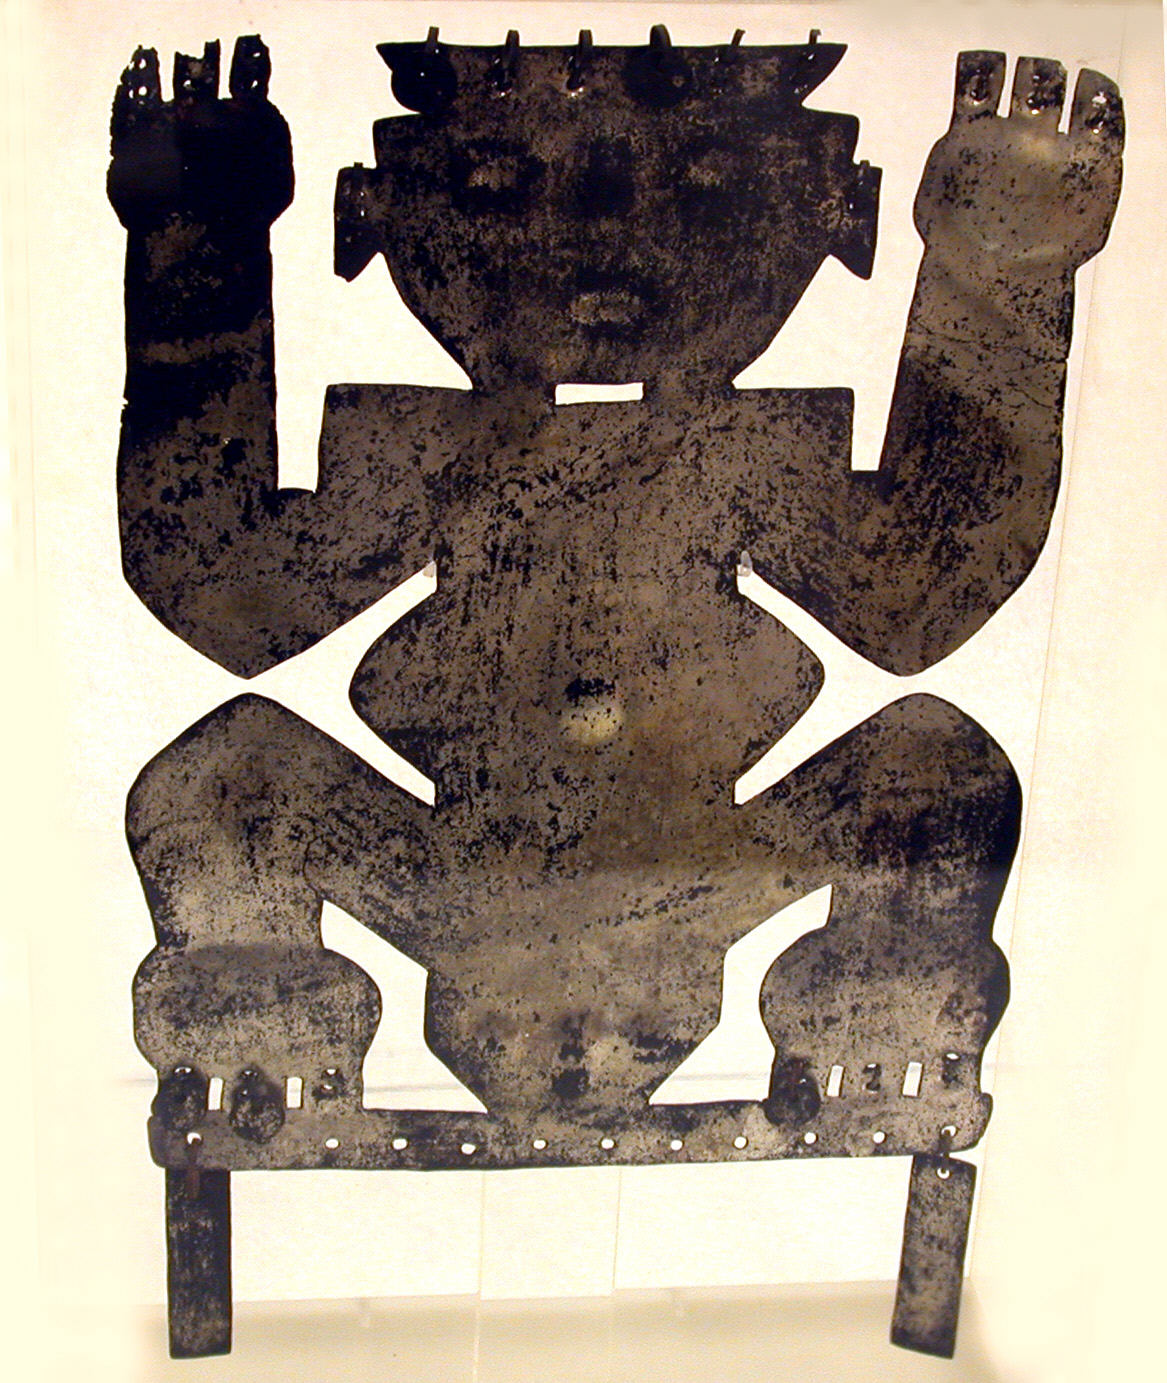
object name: ornament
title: Copper Figure Ornament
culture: vicús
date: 300 BCE-200 CE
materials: copper, silver gilt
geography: peru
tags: men